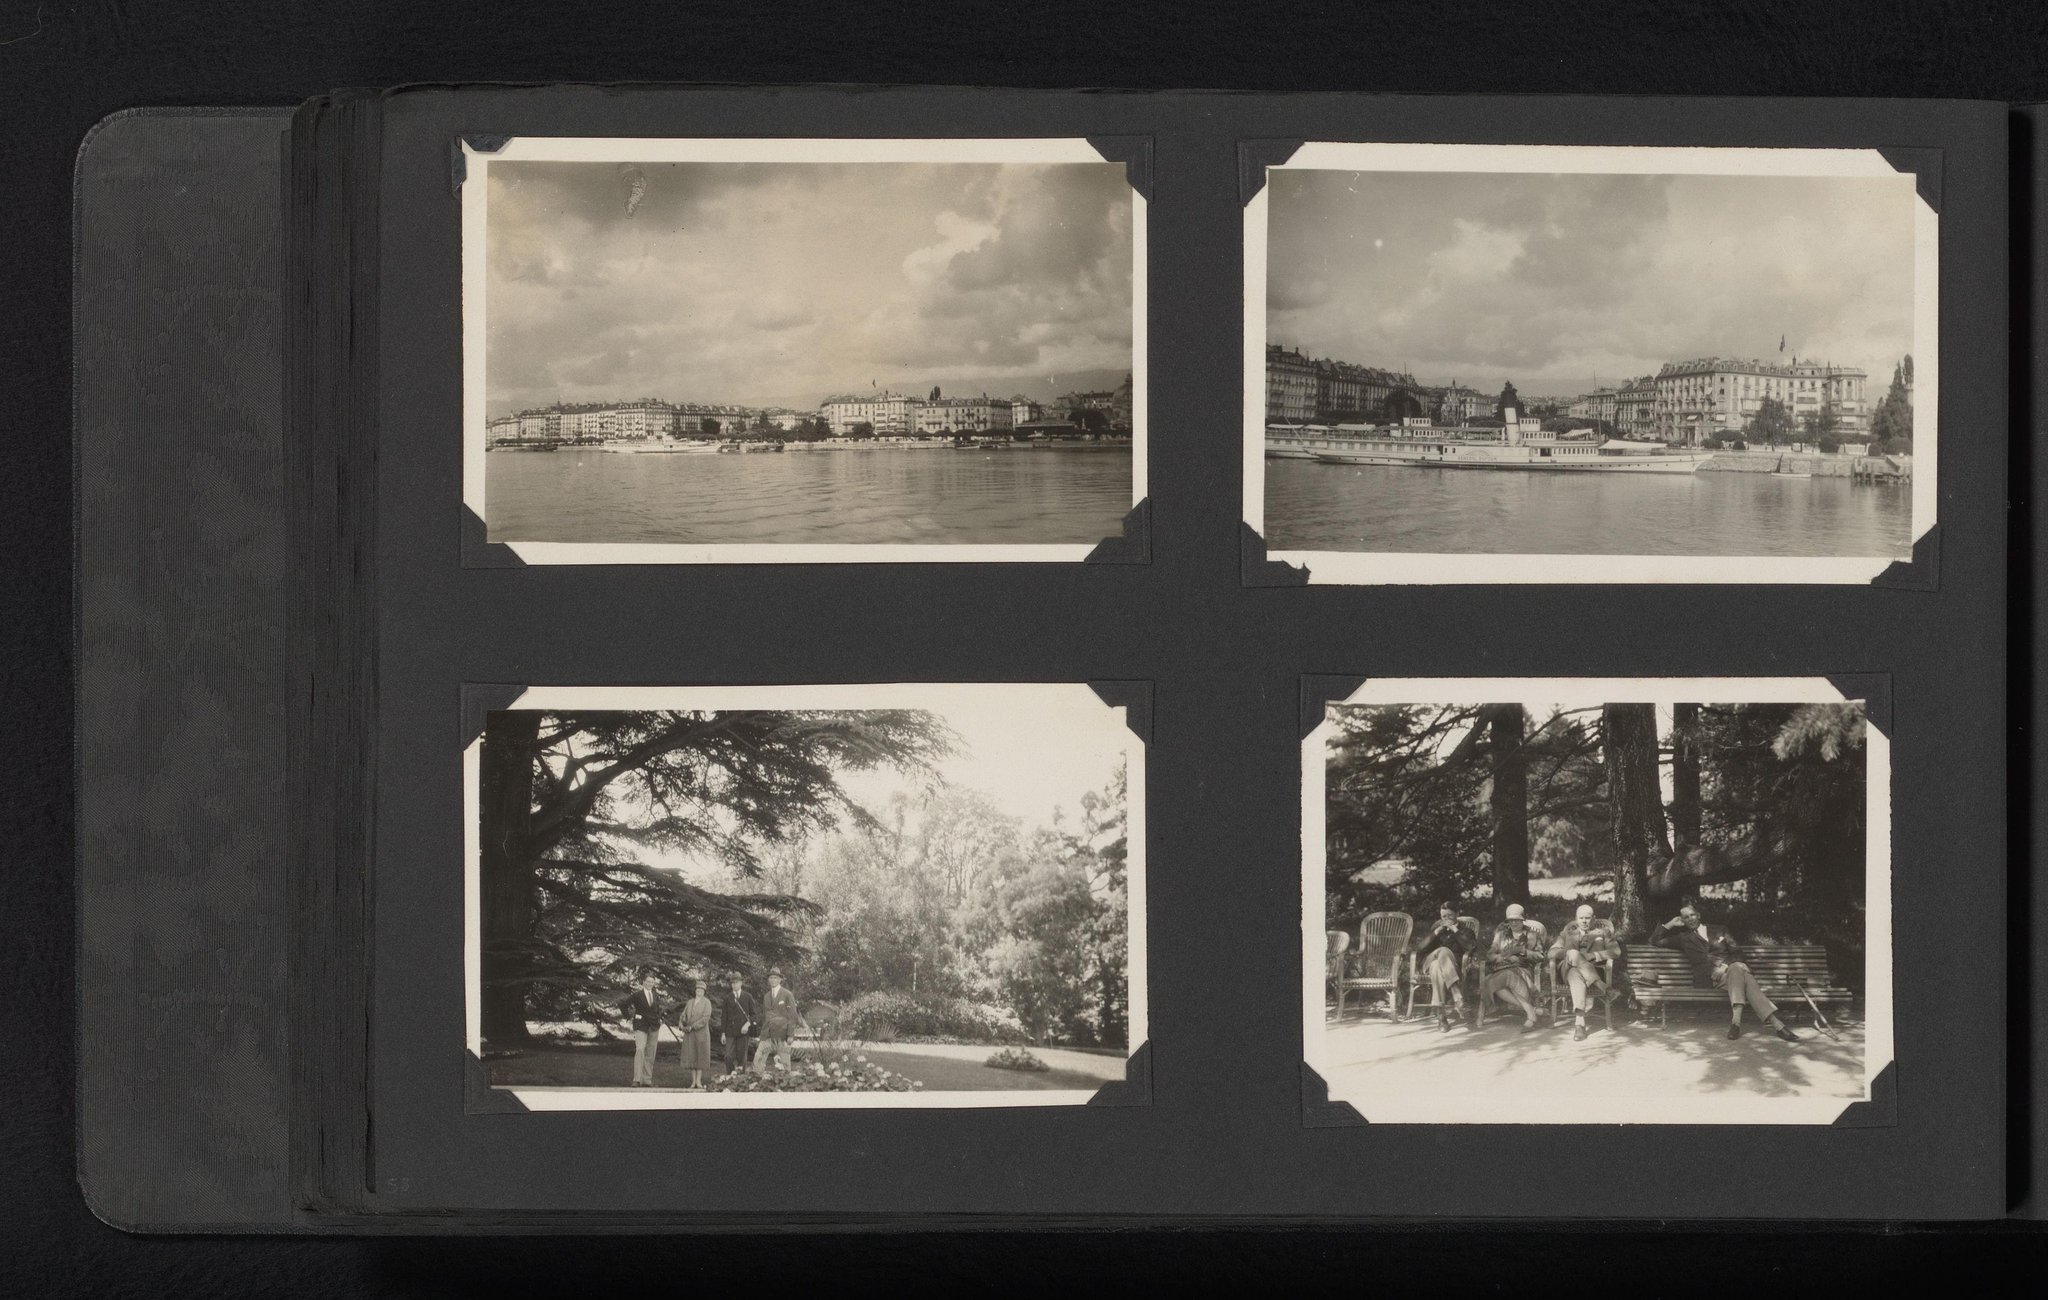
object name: album leaf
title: Vier foto's van de familie Van den Berg in Genève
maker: hendrik herman van den berg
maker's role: amateurfotograaf, jurist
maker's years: 1875-1944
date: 1908-1929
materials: paper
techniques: gelatin silver print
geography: geneva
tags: batavia, hendrik herman van den berg, the hague, caroline louise van den berg-van den berg, carel frederik van den berg (cay), frank willem van den berg (1912-1998), the family travelling, on holiday, city-view in general; 'veduta', lake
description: Deze foto's maken deel uit van een album.